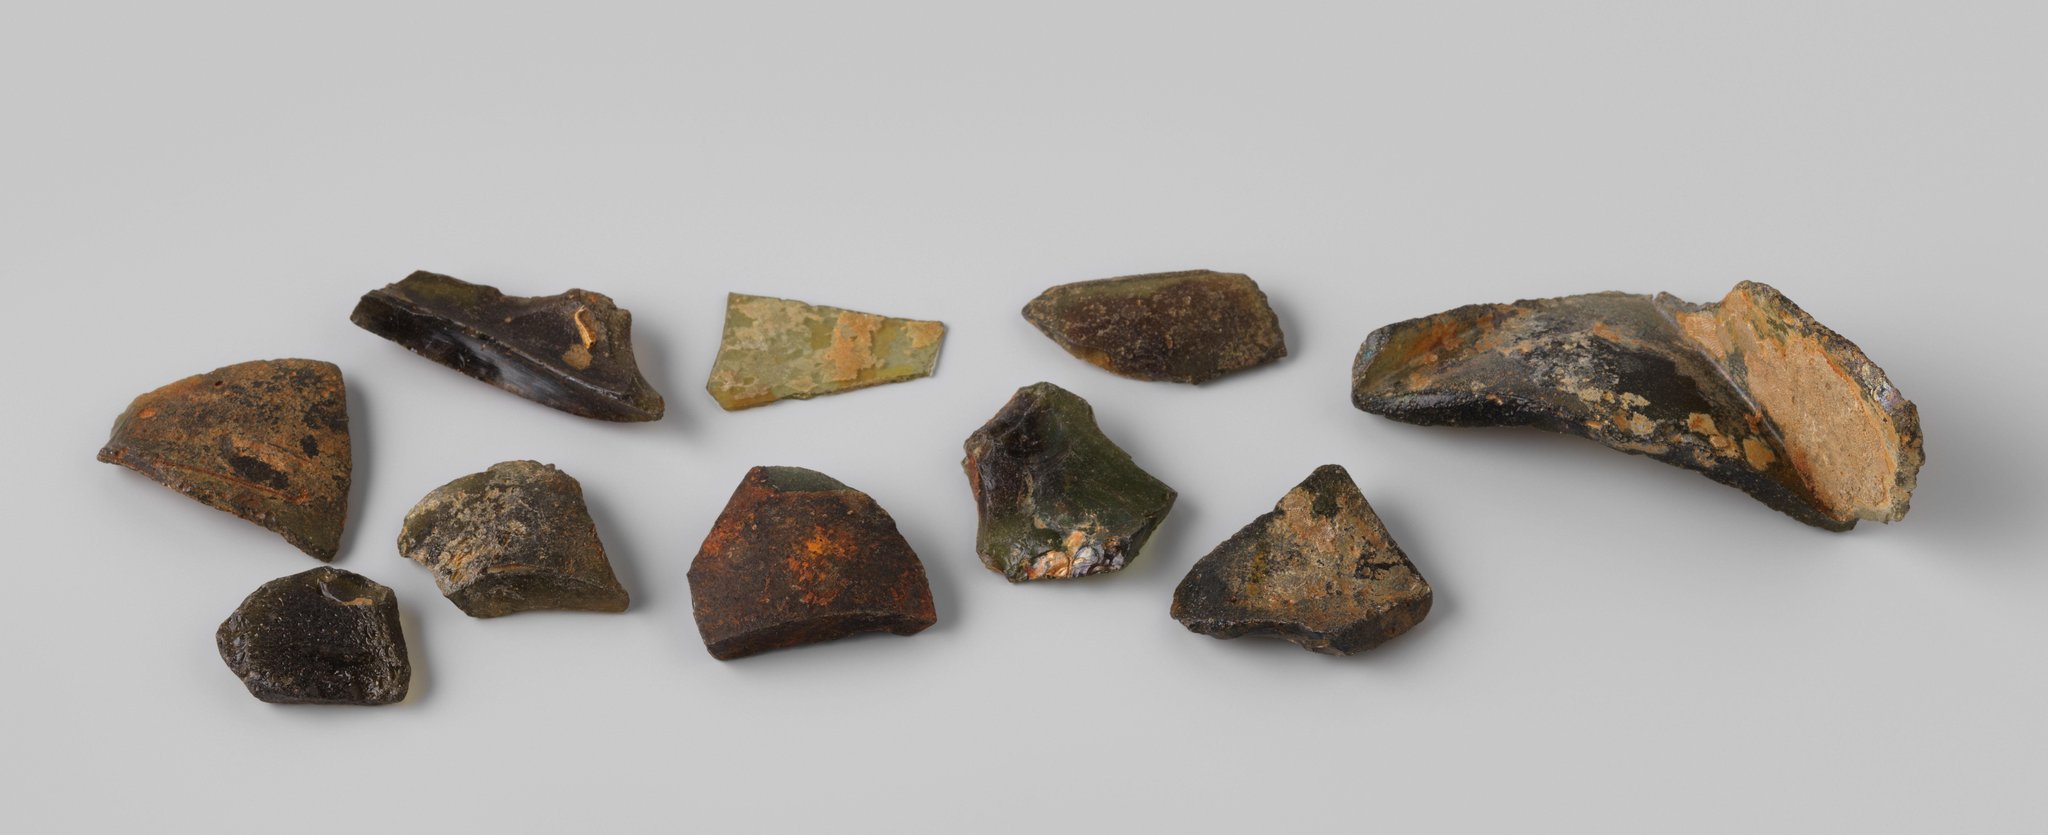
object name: sherd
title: Fragment en scherf van een kelderfles en scherven van wijnflessen uit het wrak van de Oost-Indiëvaarder Hollandia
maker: Anonymous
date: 1700-1743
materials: glass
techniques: green glass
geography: netherlands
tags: verenigde oostindische compagnie, hollandia (schip), annet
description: Case bottle, fragm of base, corner, sim. NG 1980-27H1872b.